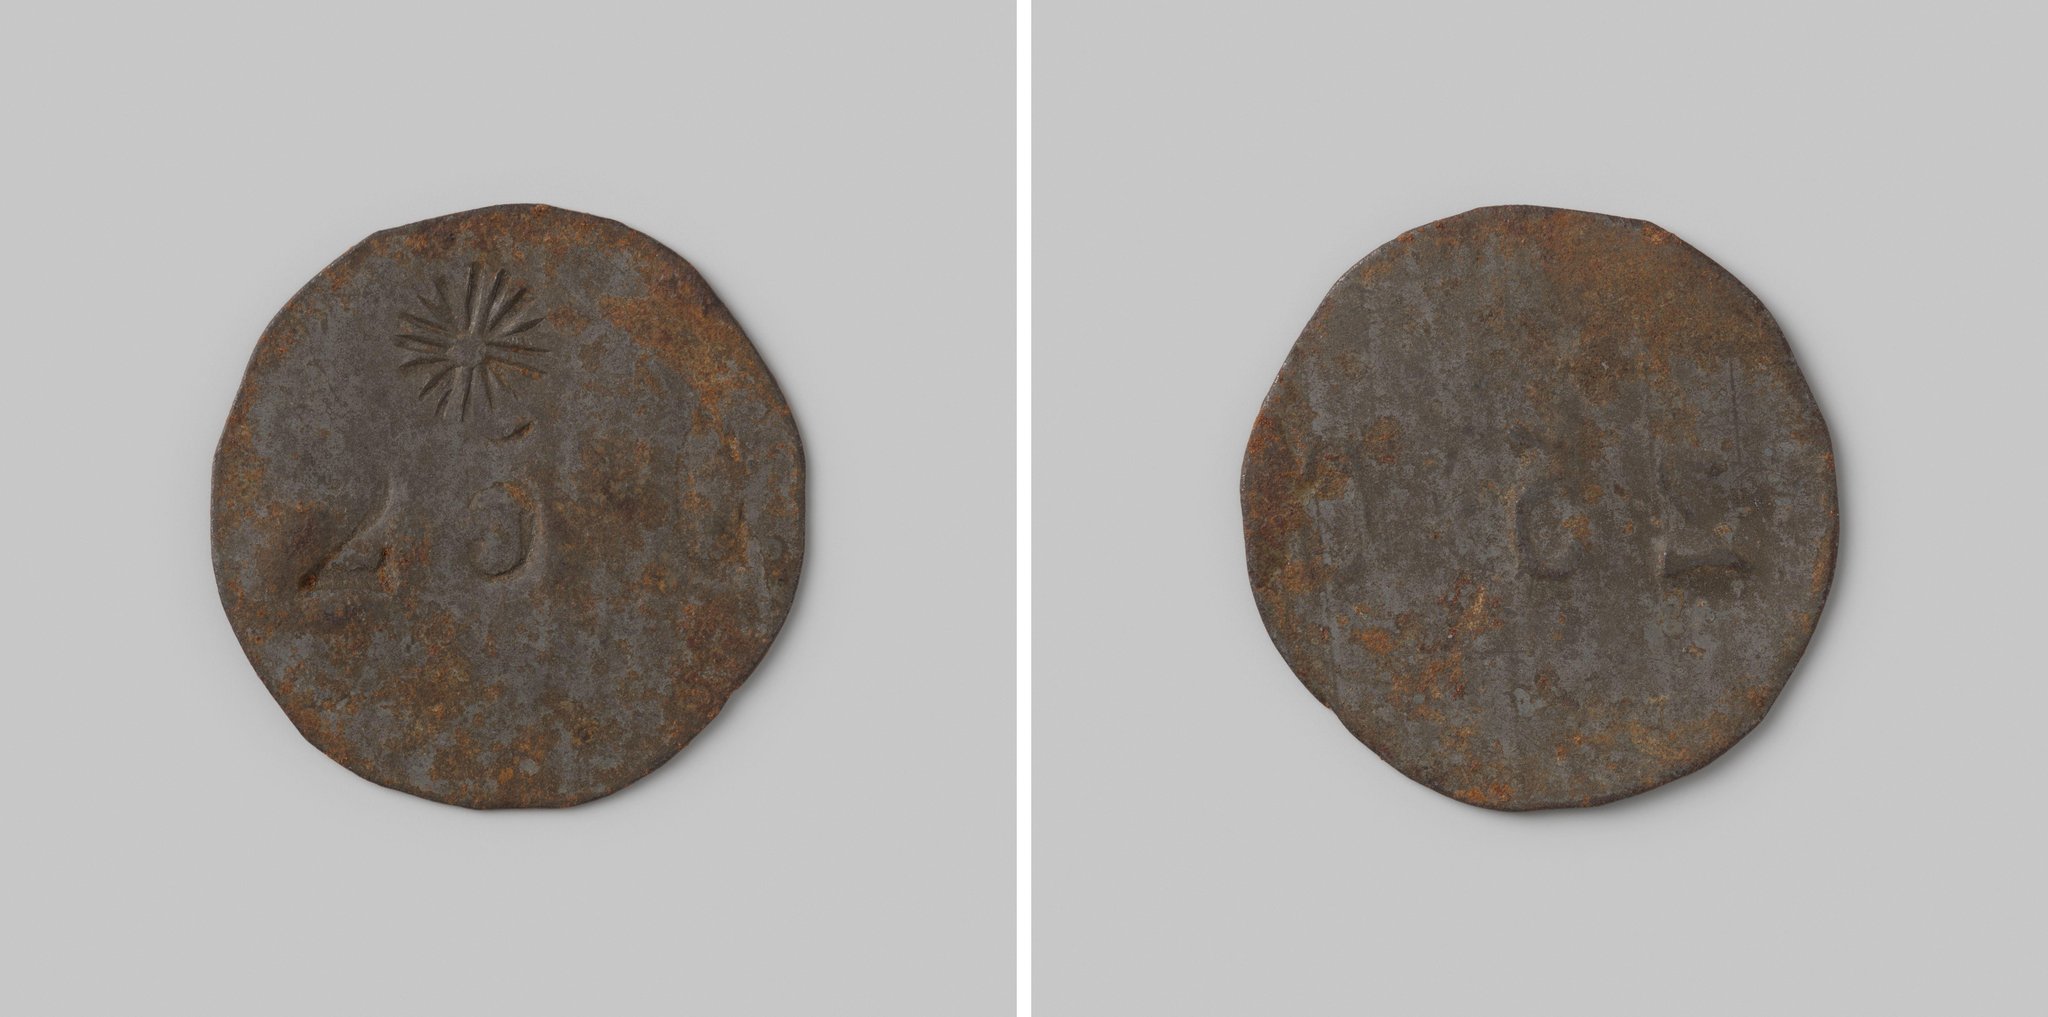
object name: history medal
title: Betaalpenning van 25 cents van de Coöperatieve Winkelvereeniging Eendracht Maakt Magt te Hilversum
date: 1875-1900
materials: zinc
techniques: printing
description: Rond zinken plaatje met inwaartse instempelingen (ster) / 25 C